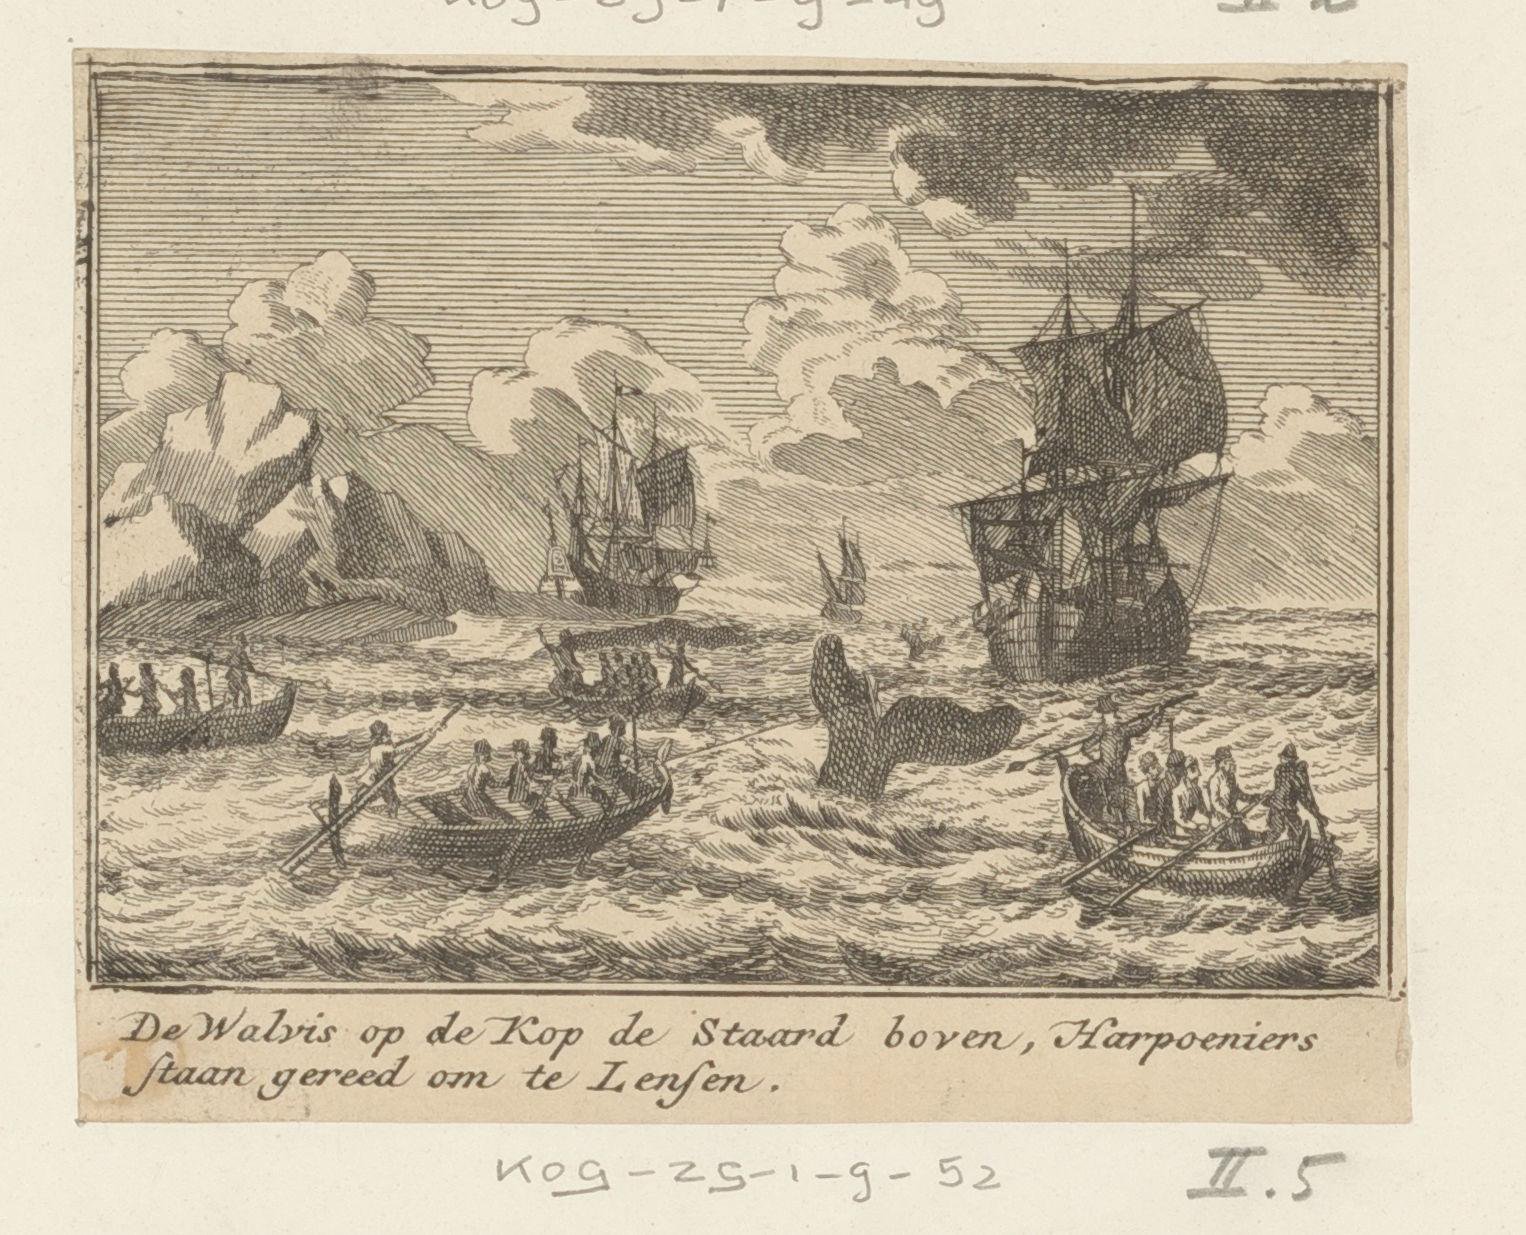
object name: print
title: Geharpoeneerde walvis met de staart boven het water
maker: Anonymous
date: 1720-1770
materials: paper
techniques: engraving, etching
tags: ships (in general), whale fishery, whaling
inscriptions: collector's mark: Lugt 1641, stamp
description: Prenten zijn een verkleinde versie van de serie Groote Visserij, Visschers Atlas tot Amsterdam. Prenten door Adolf van der Laan, naar tekeningen van Sieuwert van der Meulen en uitgegeven door Pieter Schenk II. De serie bestaat uit zeventien platen over de haringvisserij en zestien platen over de walvisvangst. De serie is waarschijnlijk rond 1720 uitgegeven. De kleine prenten werden met vier voorstellingen op een plaat gedrukt. Elke afbeelding werd genummerd.